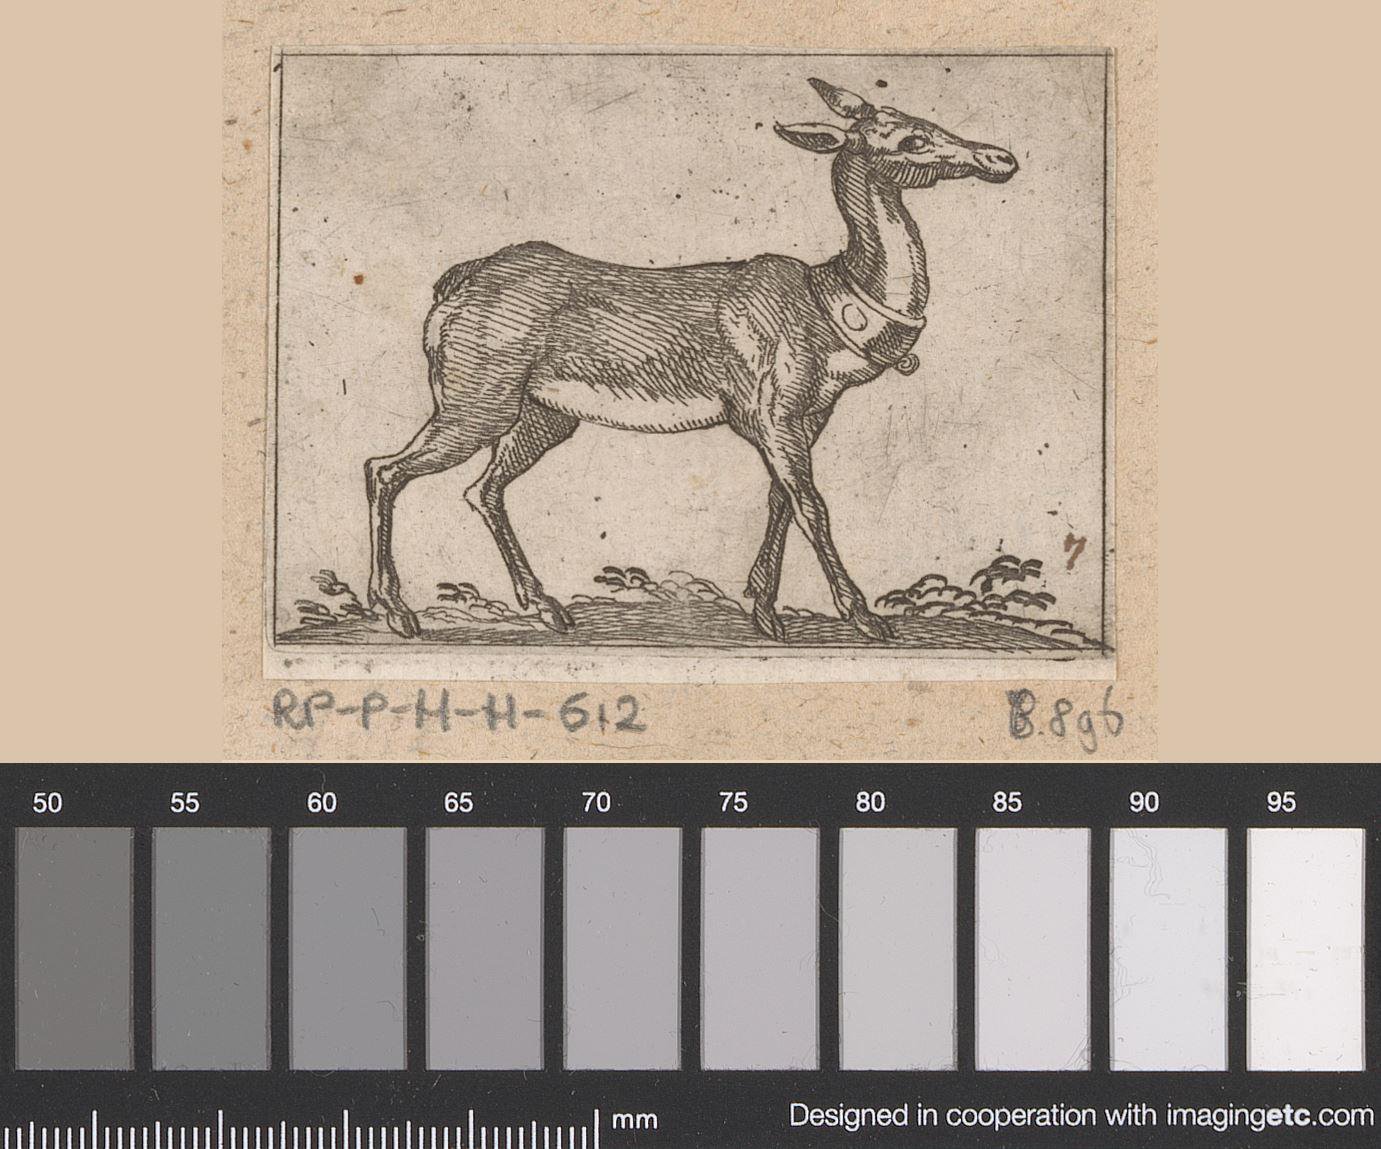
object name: print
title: Verschillende dieren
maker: antonio tempesta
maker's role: draughtsman, painter, print maker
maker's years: 1555-1630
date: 1565-1630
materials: paper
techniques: etching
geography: italy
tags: hoofed animals: deer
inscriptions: collector's mark: Lugt 11, number: ‘7’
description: Deze prent maakt deel uit van een reeks van 28 prenten van dieren.